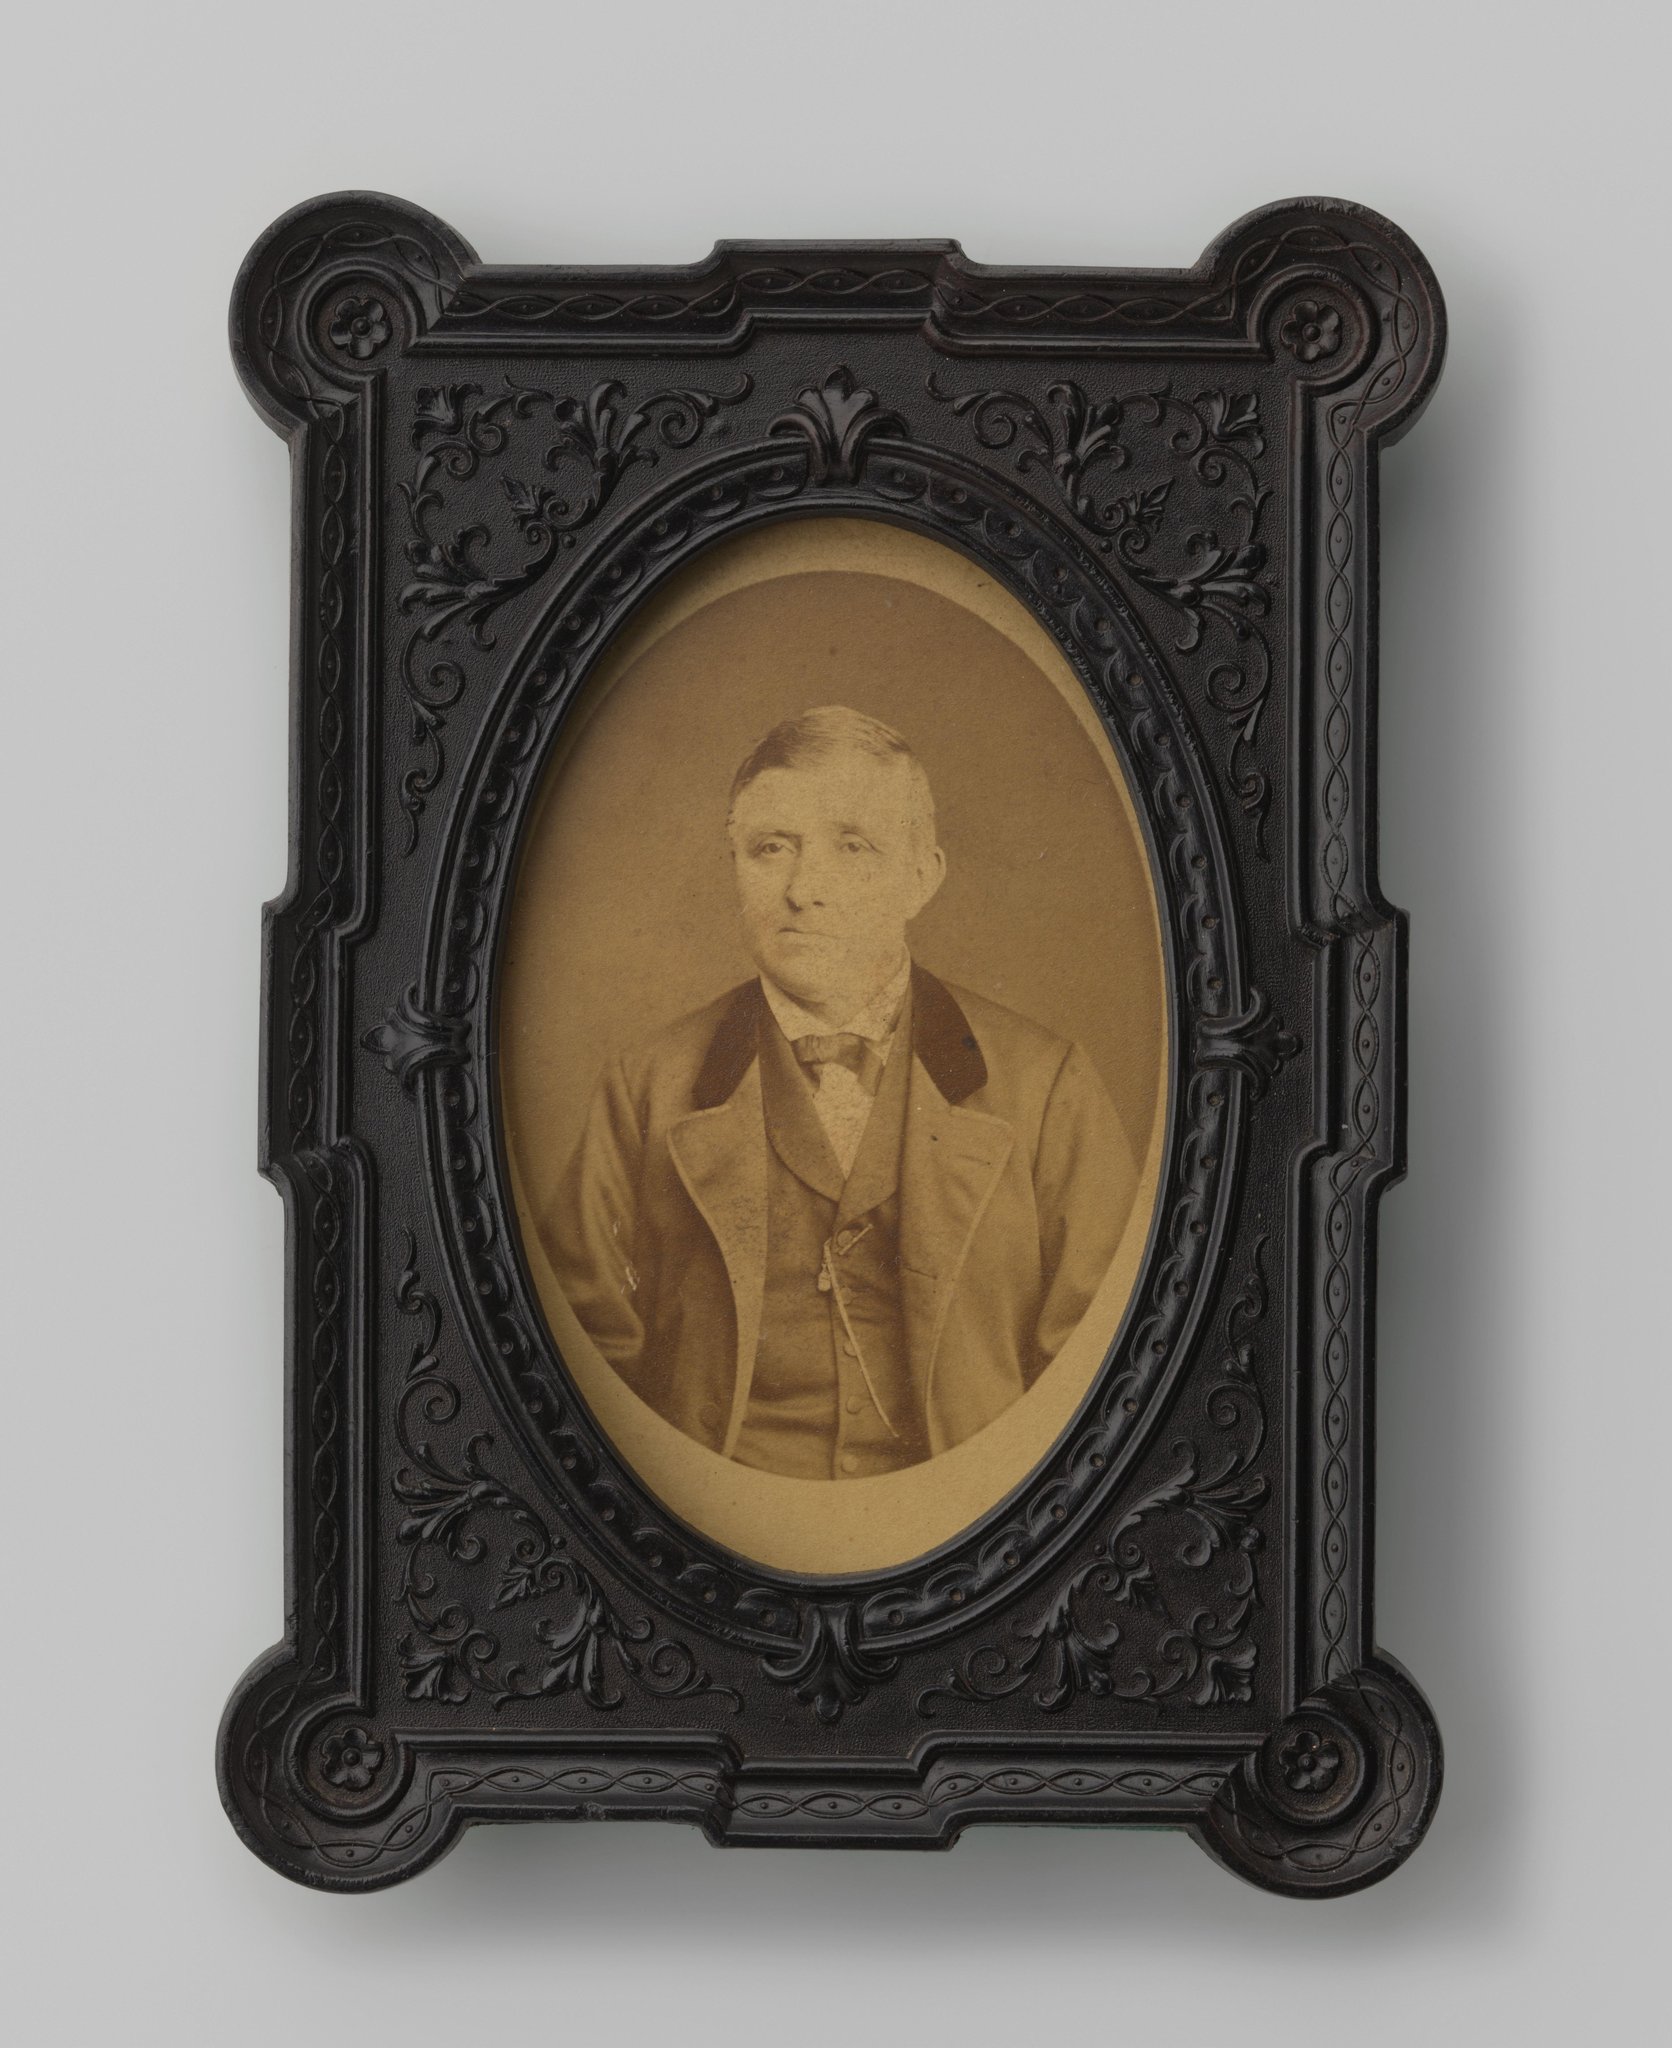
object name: frame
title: Portret van een onbekende man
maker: Anonymous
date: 1880-1900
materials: cardboard, glass, paper, wood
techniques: albumen print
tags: adult man, anonymous historical person portrayed